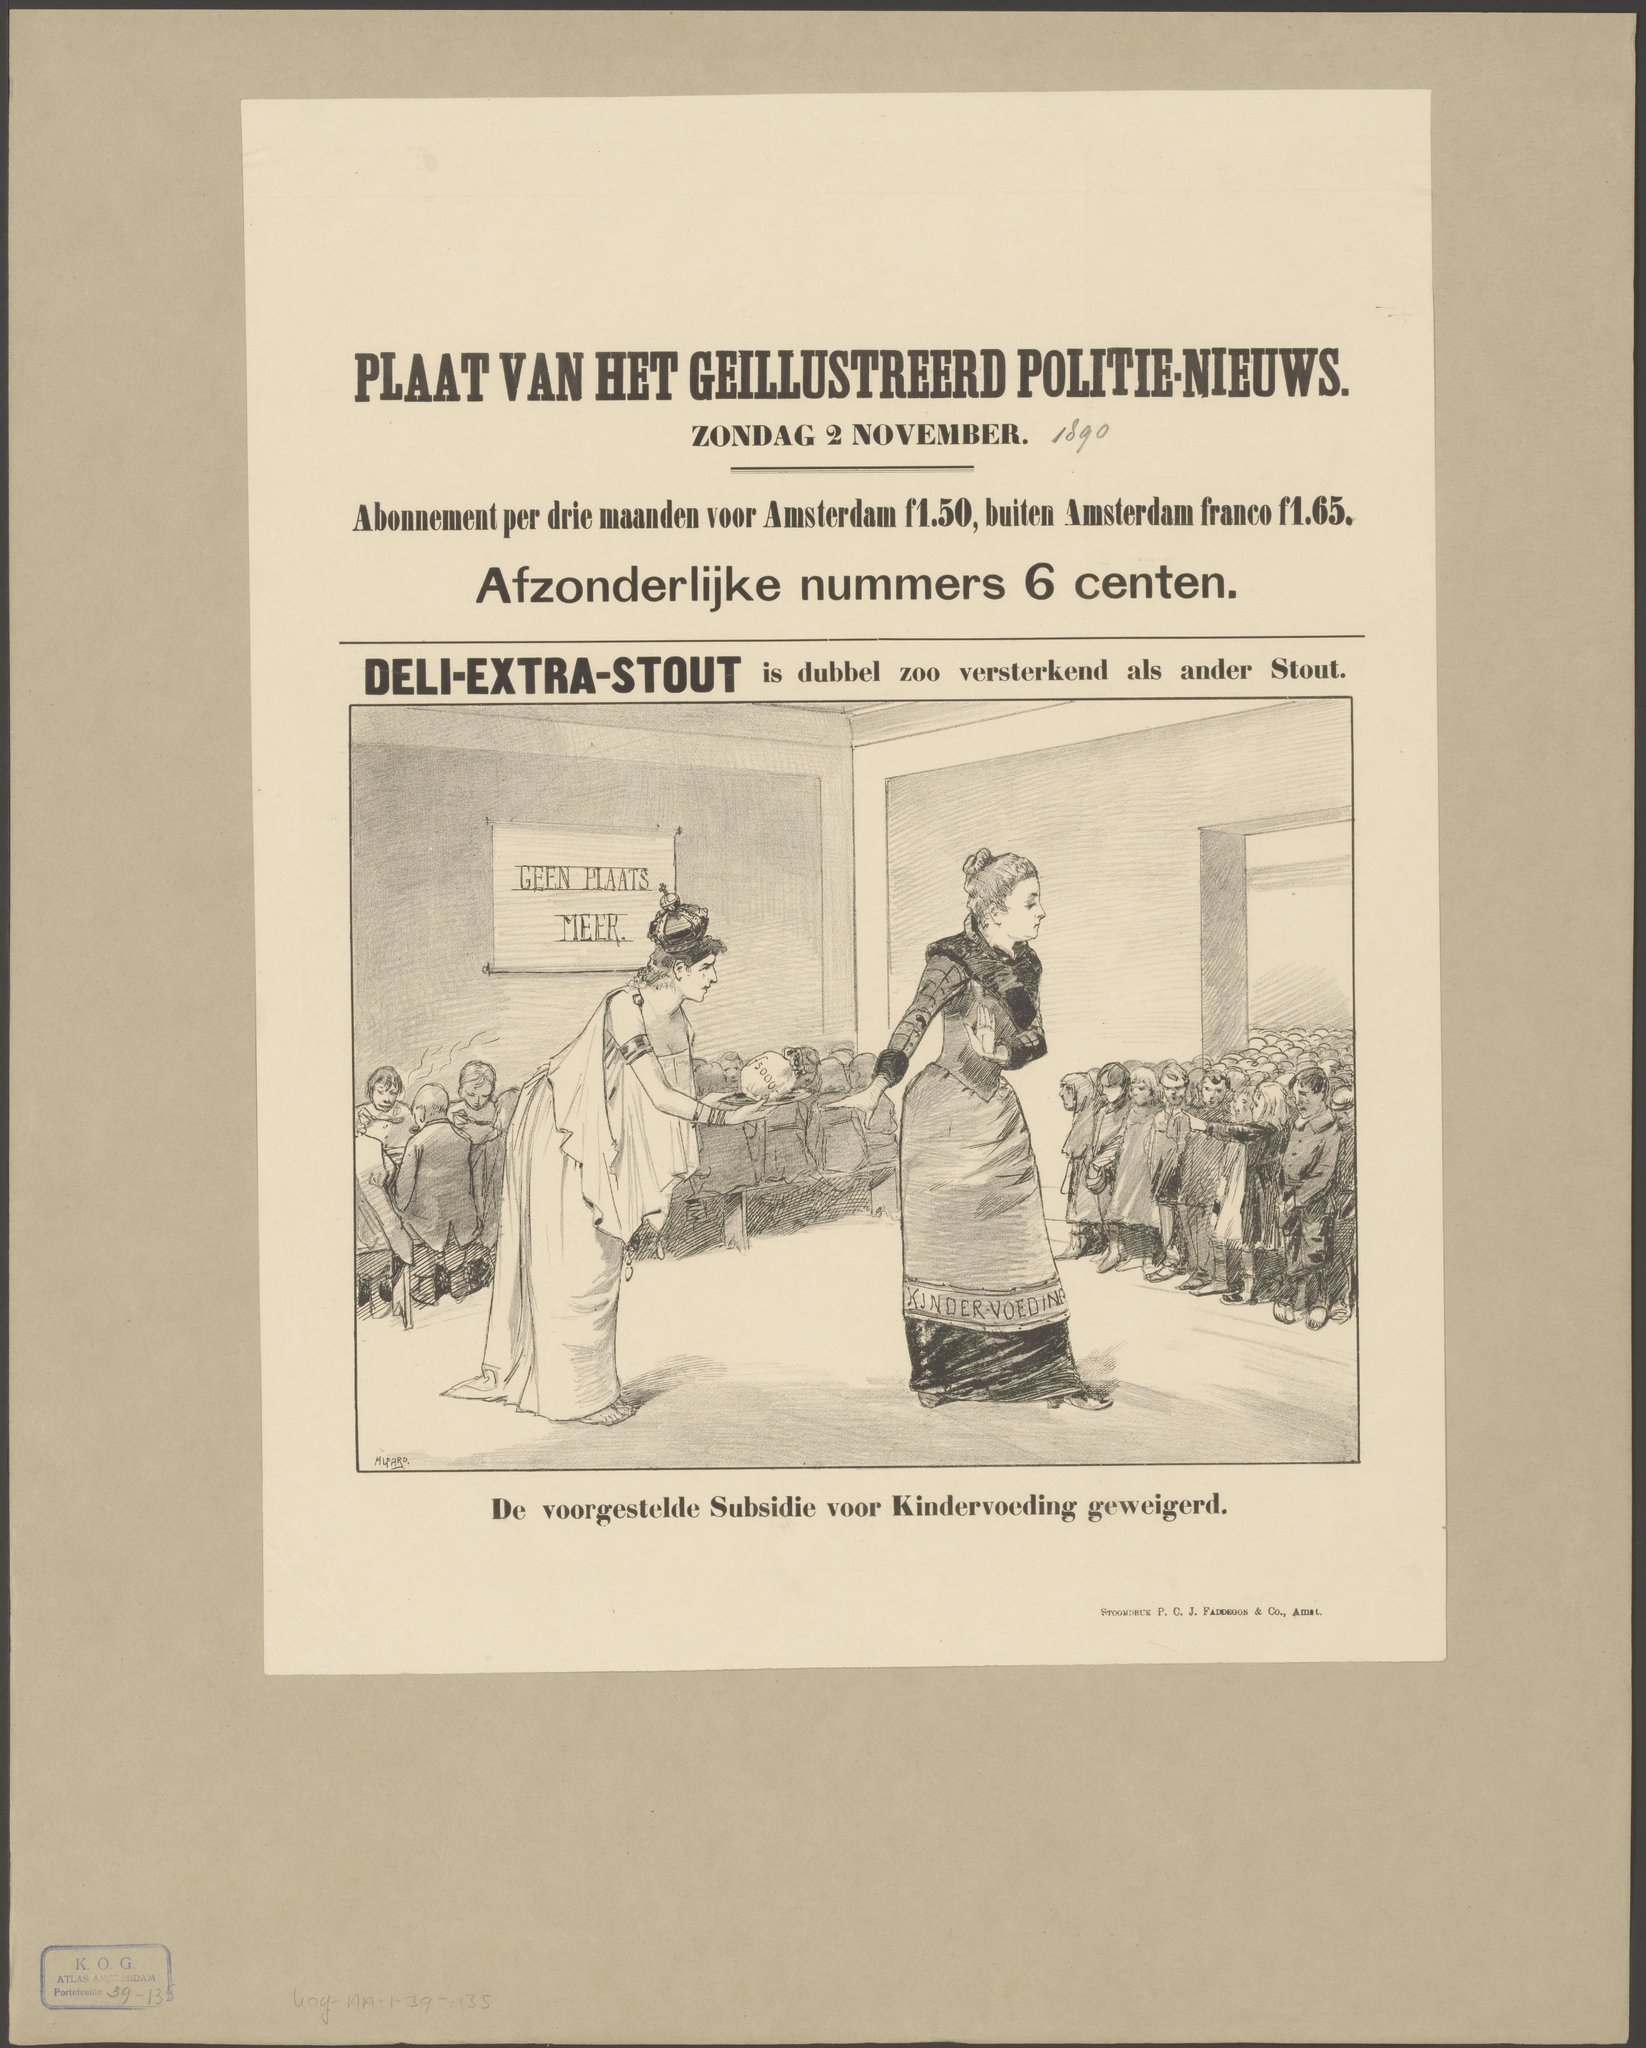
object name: cartoon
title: De voorgestelde Subsidie voor Kindervoeding geweigerd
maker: alfaro reijding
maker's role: draughtsman, engineer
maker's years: 1863-1930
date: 1890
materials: paper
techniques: letterpress printing, lithograph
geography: amsterdam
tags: hunger, purse, money-bag, personification of a city, town-patron(ess), child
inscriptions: collector's mark: Lugt 1641b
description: Onderwerpsrubriek binnen de Atlas Amsterdam: Armwezen en liefdadige instellingen: IV. Prenten betrekking hebbende op Philantropie.